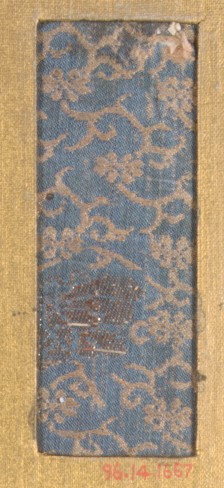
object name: piece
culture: japanese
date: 1701-1900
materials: silk